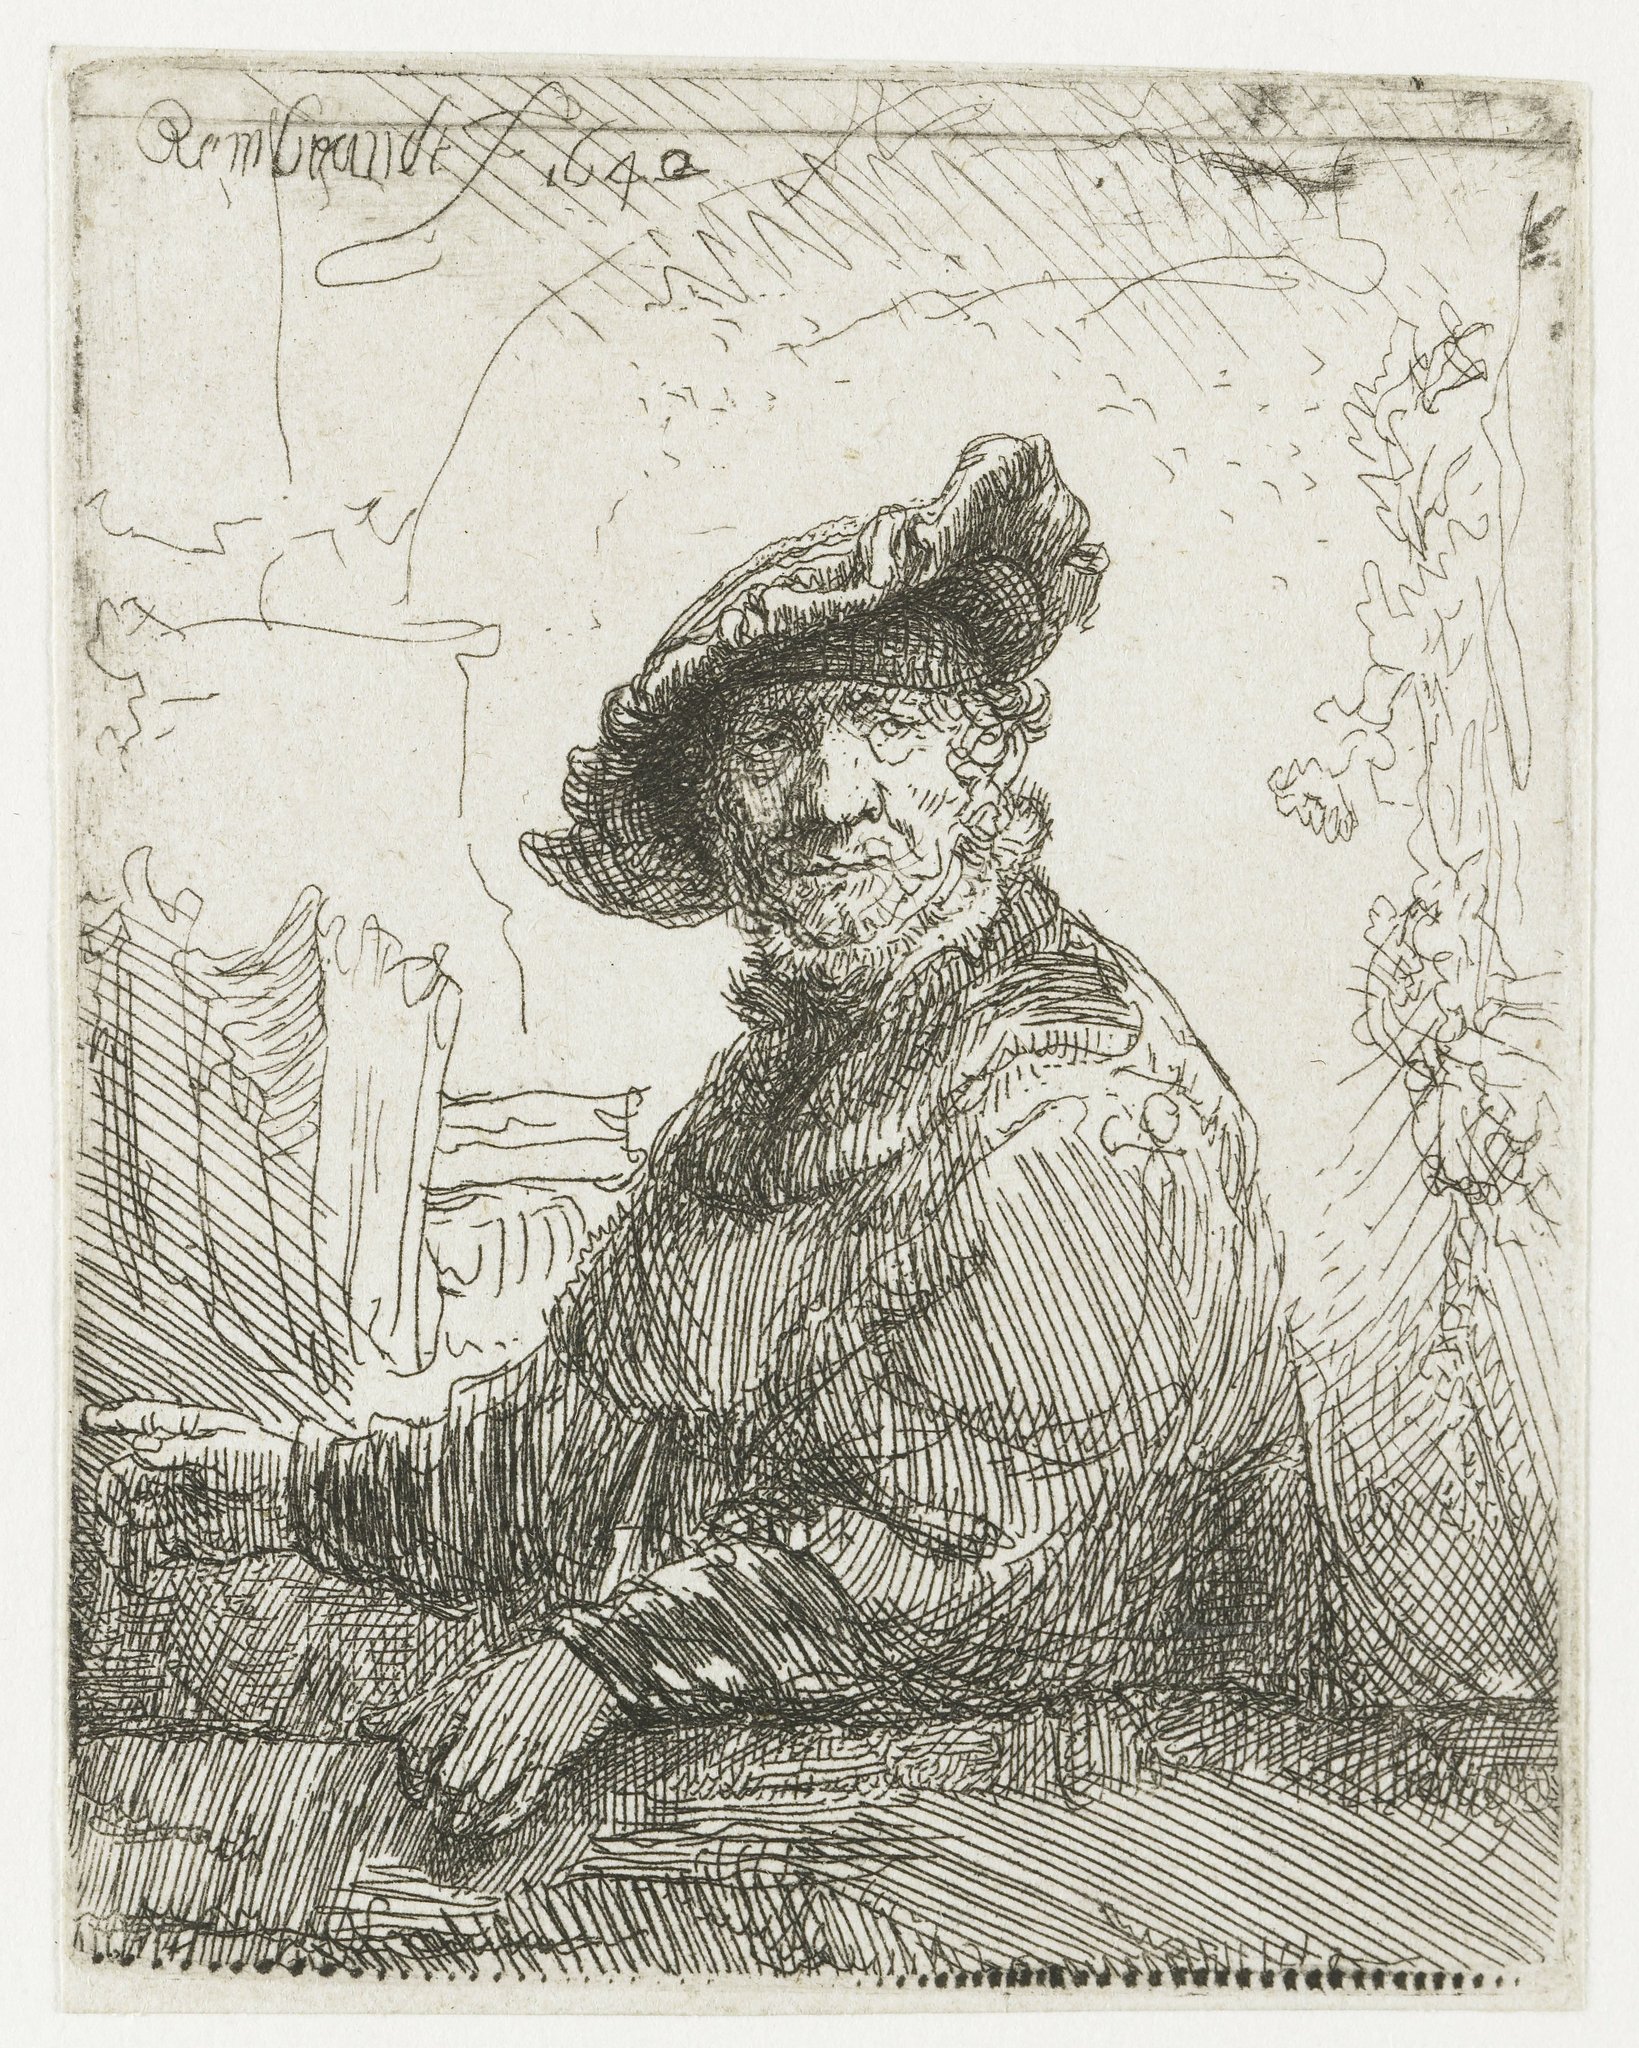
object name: print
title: Man in an Arbour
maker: rembrandt van rijn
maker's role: draughtsman, painter, print maker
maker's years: 1606-1669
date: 1642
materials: paper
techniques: etching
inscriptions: signature and date: ‘Rembrandt f 1642’, collector's mark: Lugt 240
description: The attire of these men leaves no doubt that they were intended as tronies. They wear berets, one of which is decorated with a cloak clasp, or a Polish fur cap (kutchma). In the print with the fur cap, the clasp simply adorns the man’s chest. The faces are sometimes so specifically rendered that they strike one as being portraits.